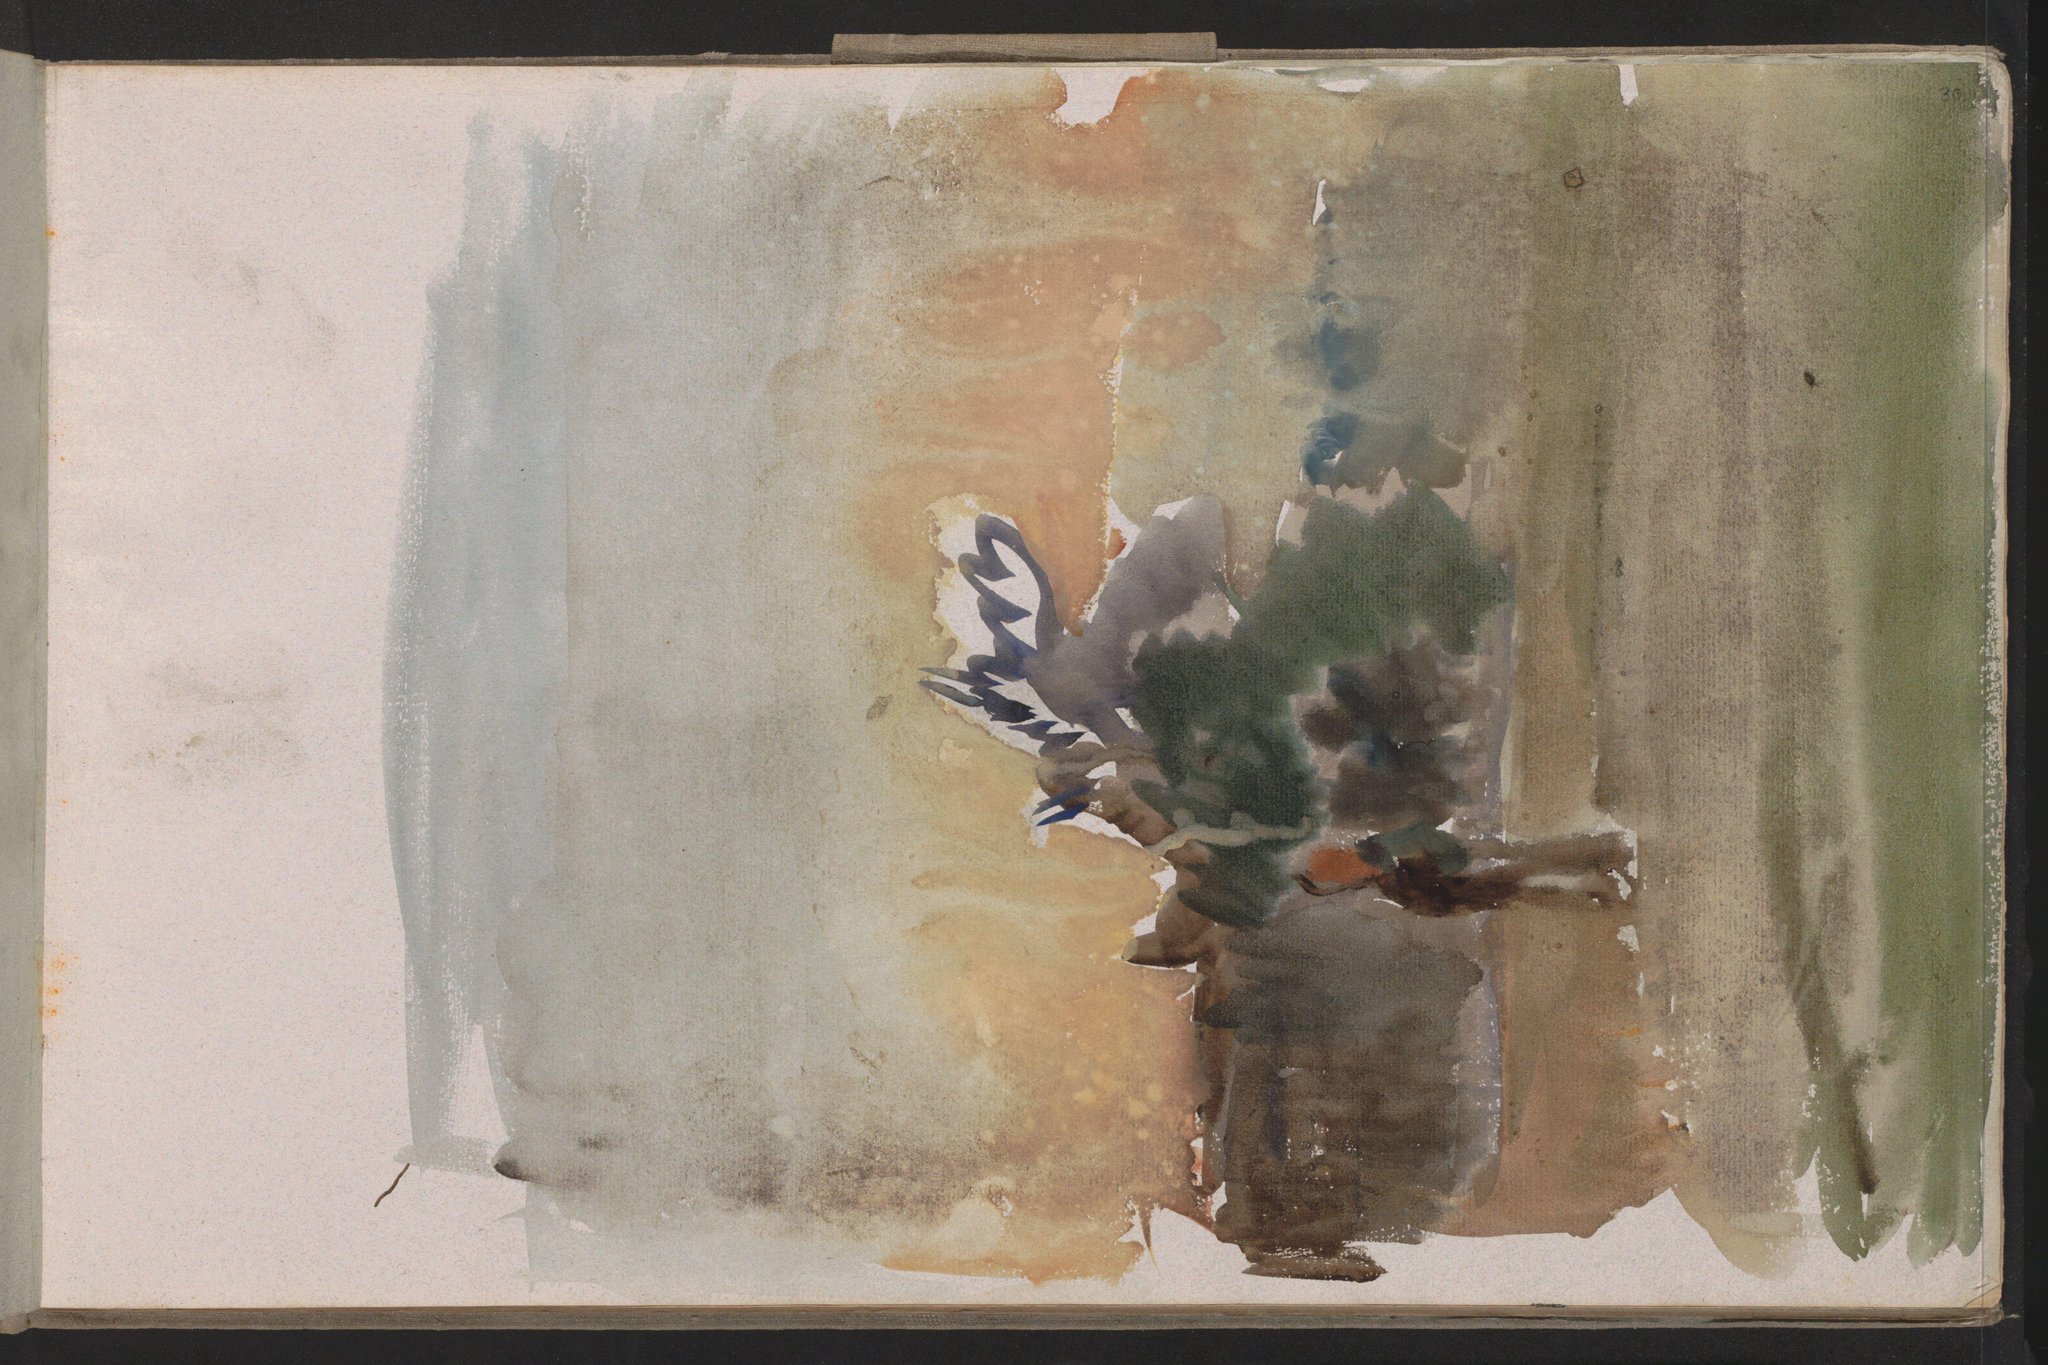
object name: sketchbook leaf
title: Weide met bomen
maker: albert neuhuys (1844-1914)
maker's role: draughtsman, painter, print maker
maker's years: 1844-1914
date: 1854-1914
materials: paper, watercolor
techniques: brush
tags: trees, meadow, pasture (+ landscape with figures, staffage)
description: Op de voorgrond een figuur. Blad 30 recto uit een schetsboek met 51 bladen.